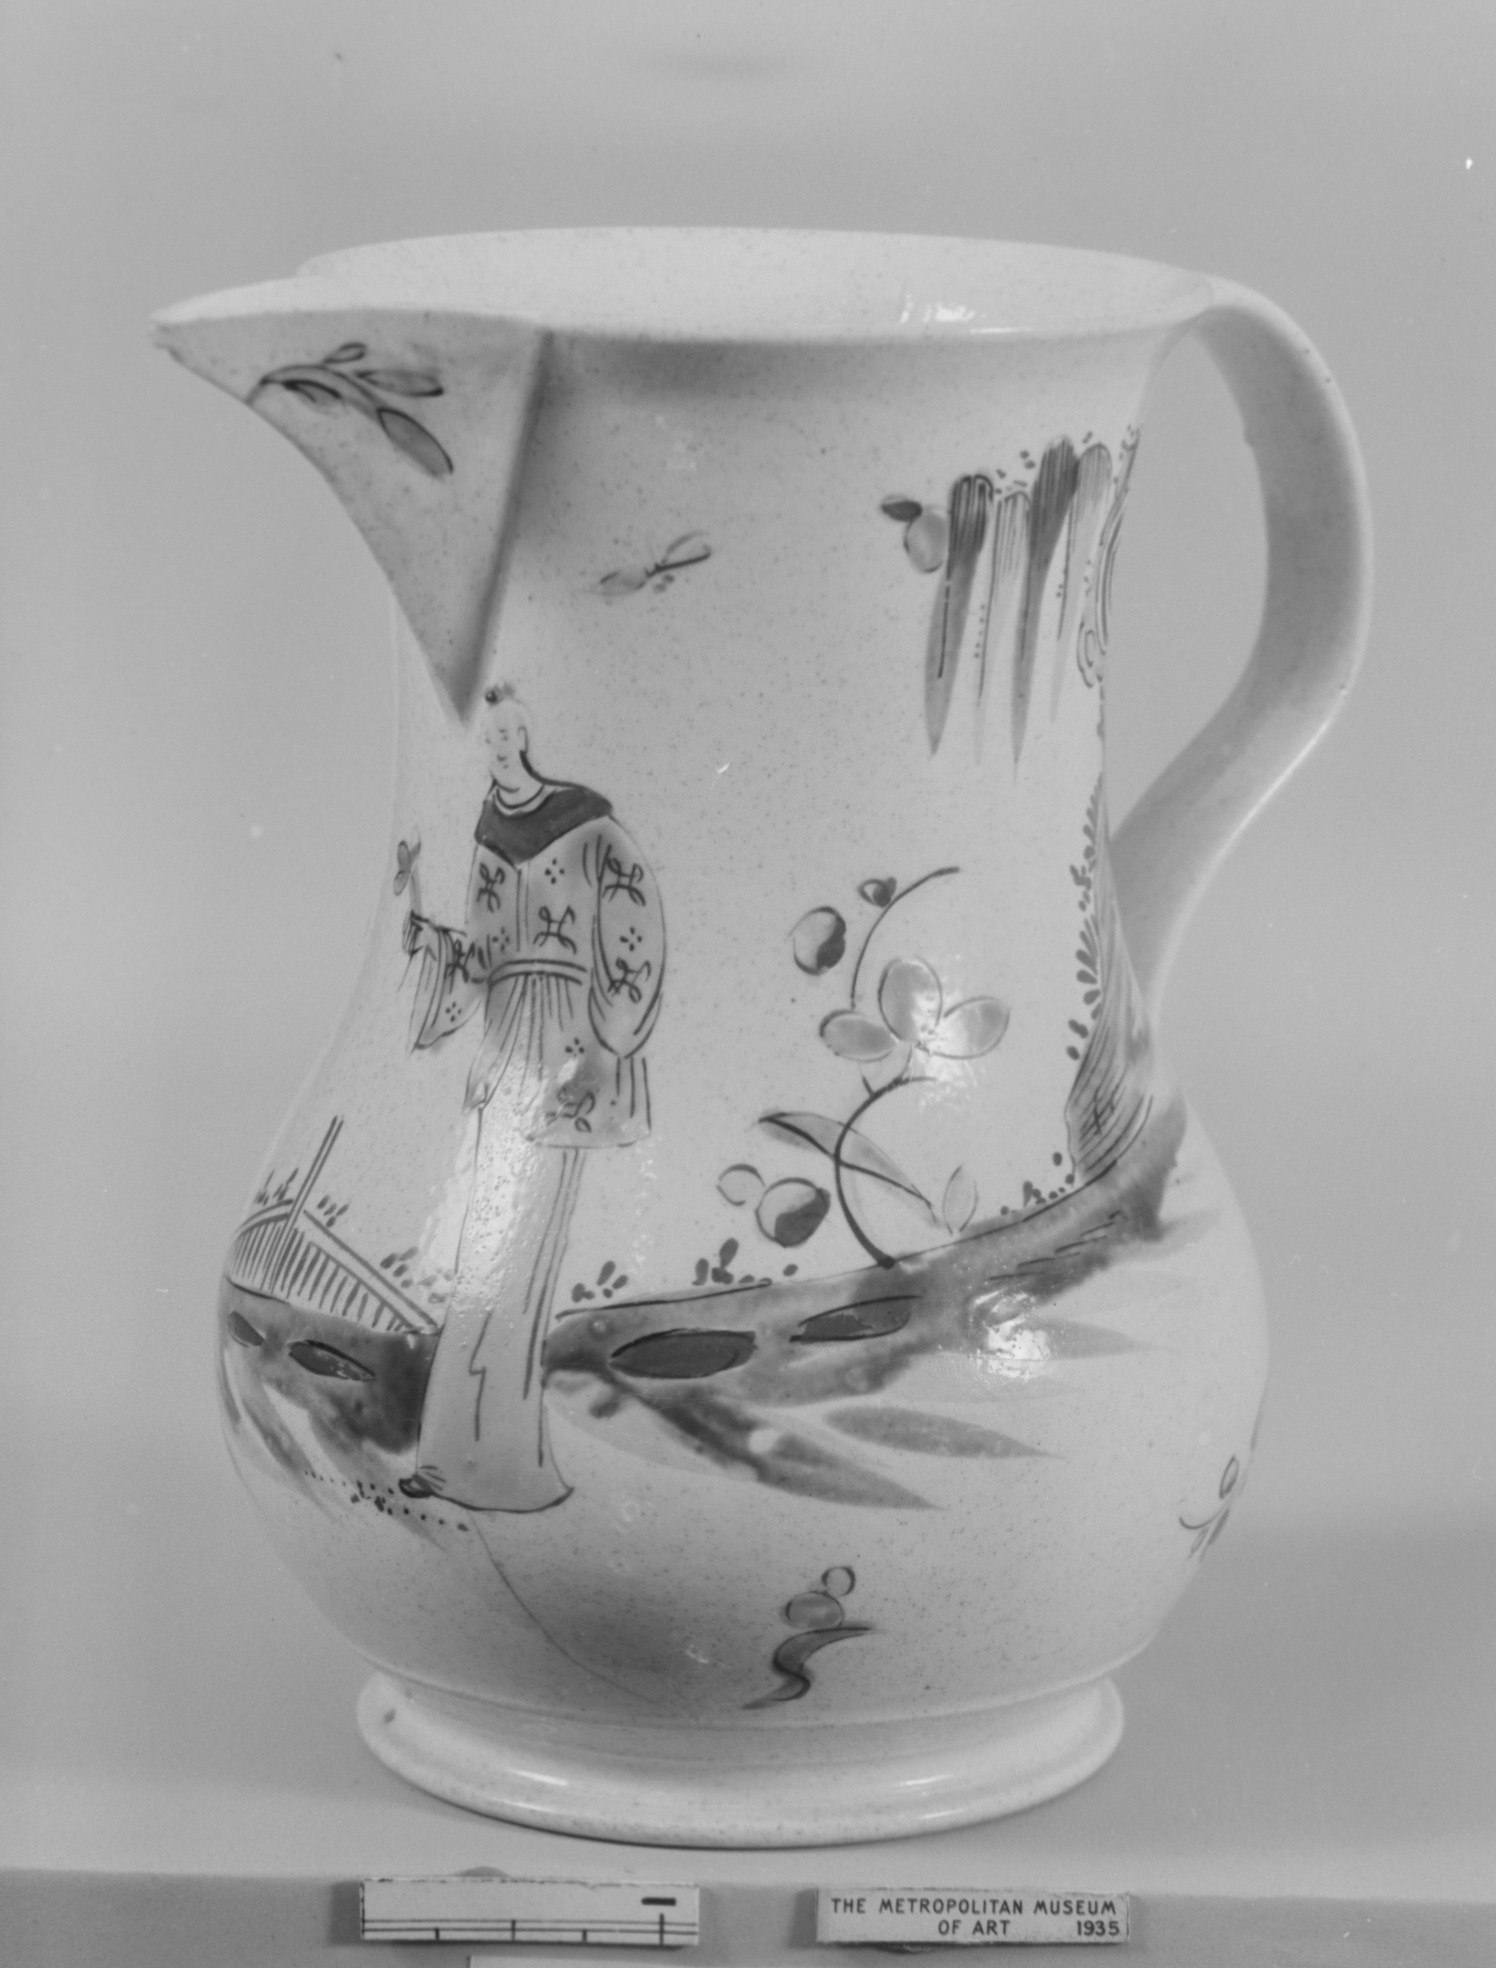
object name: cream jug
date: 1760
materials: stoneware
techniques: salt glaze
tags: men